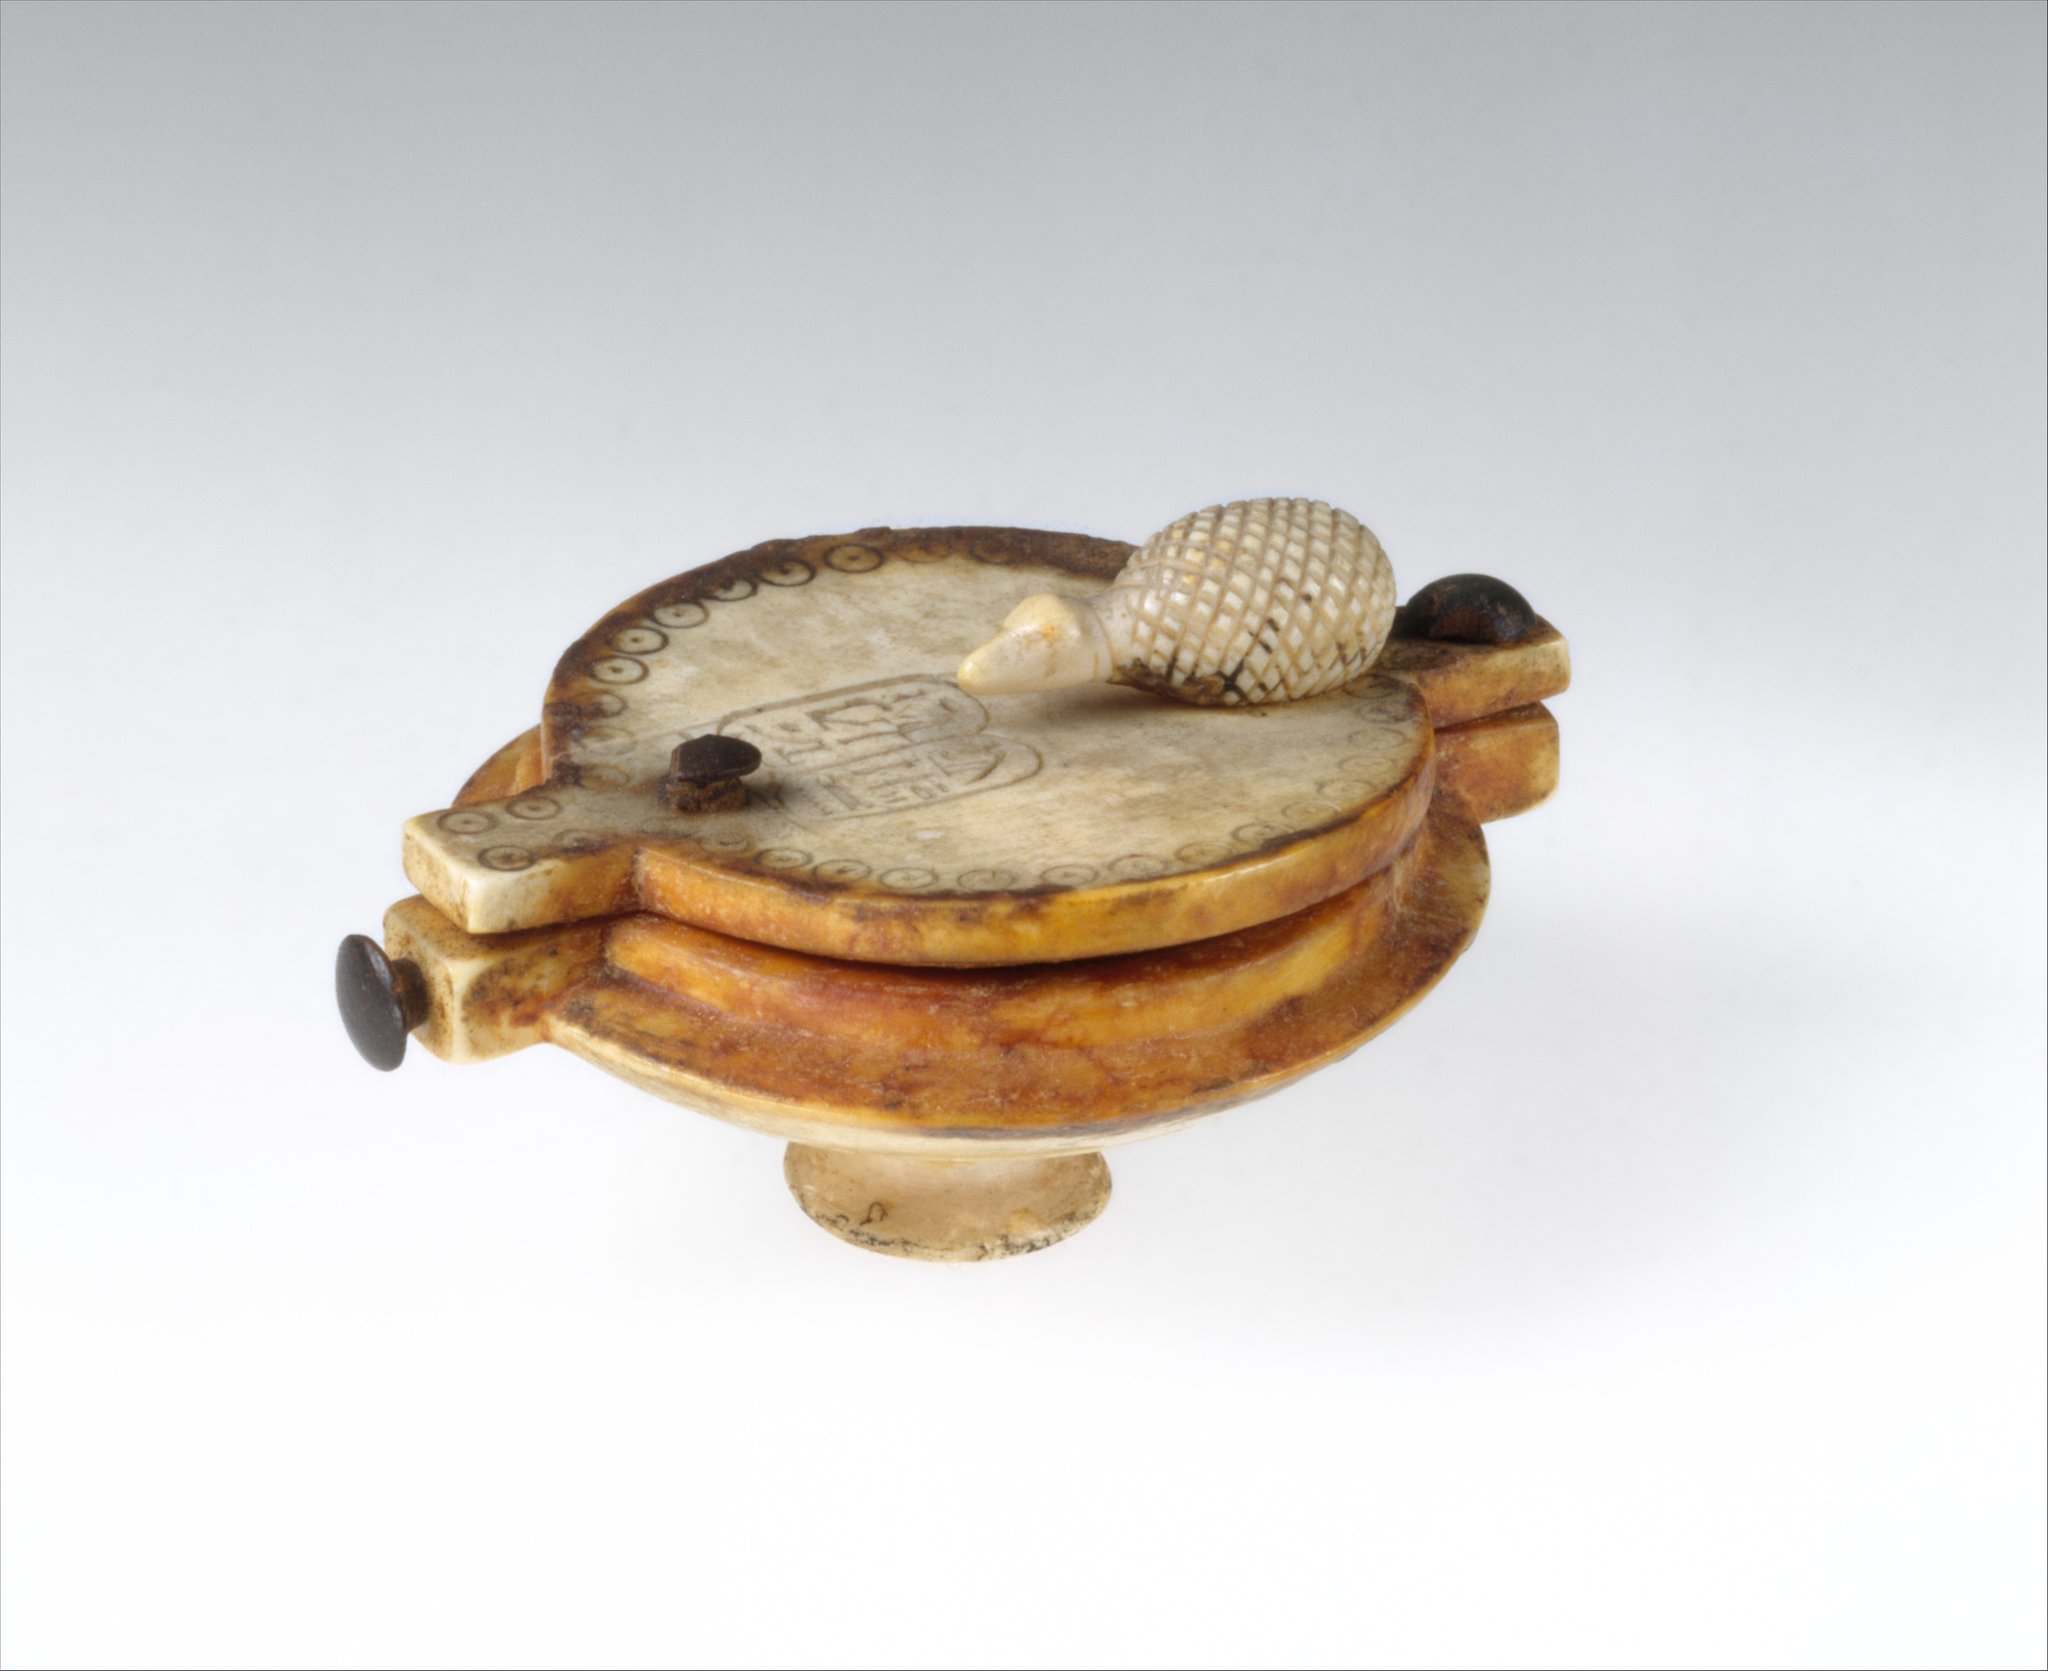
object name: cosmetic box, swivel top, cartouch of ramesses ii and queen nefertari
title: Ivory Unguent Box of Queen Nefertari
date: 1279-1213 BCE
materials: ivory, wood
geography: egypt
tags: cartouches